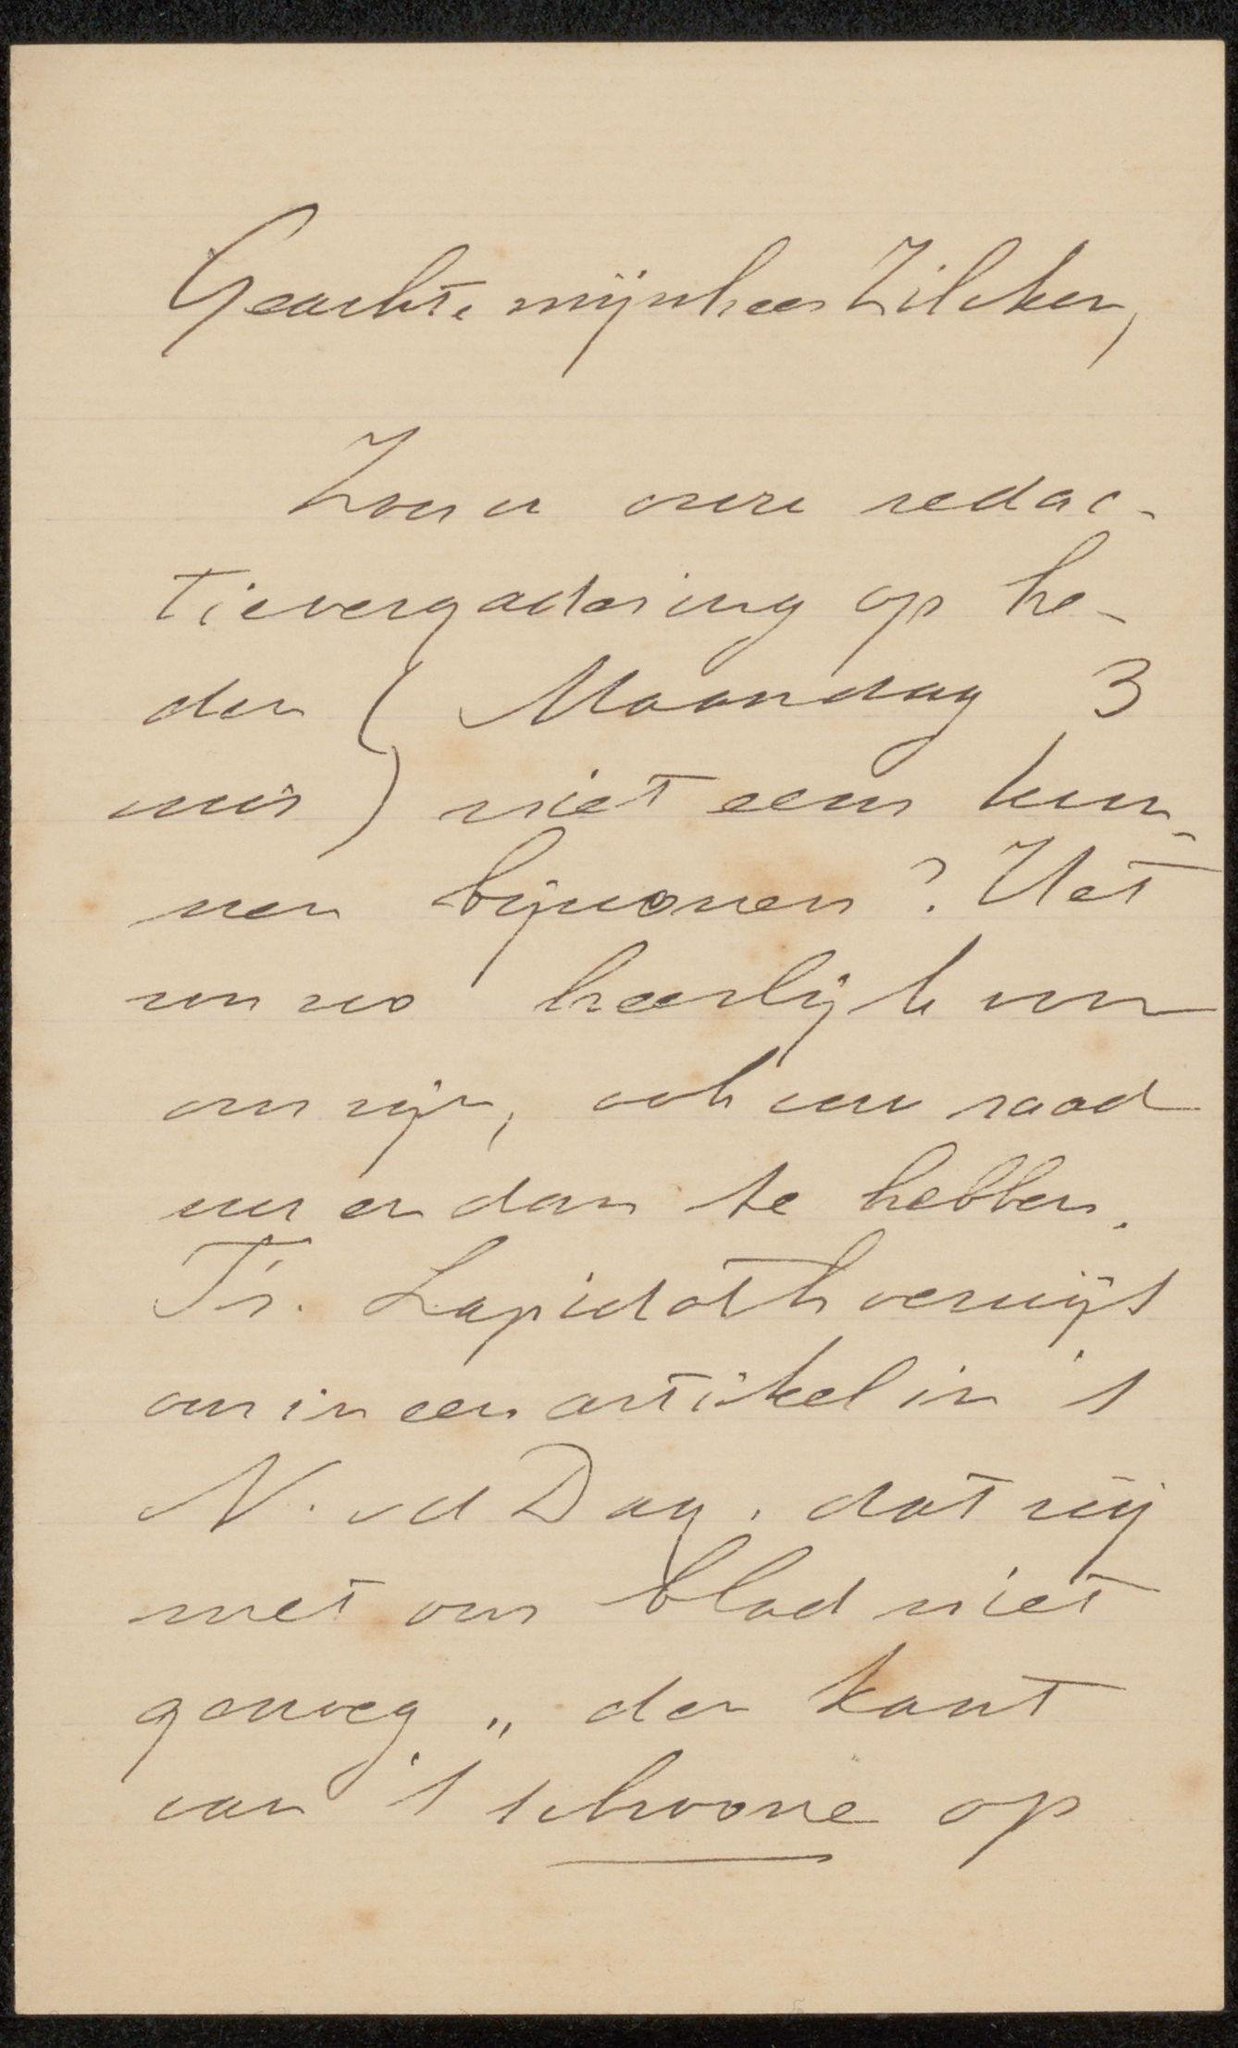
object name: letter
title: Brief aan Philip Zilcken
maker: suze groshans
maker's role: schrijver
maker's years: 1863-1944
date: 1873-1930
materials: ink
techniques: pen, writing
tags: frits lapidoth, the hague, painter, draughtsman, philip zilcken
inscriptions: collector's mark: ‘RPK’